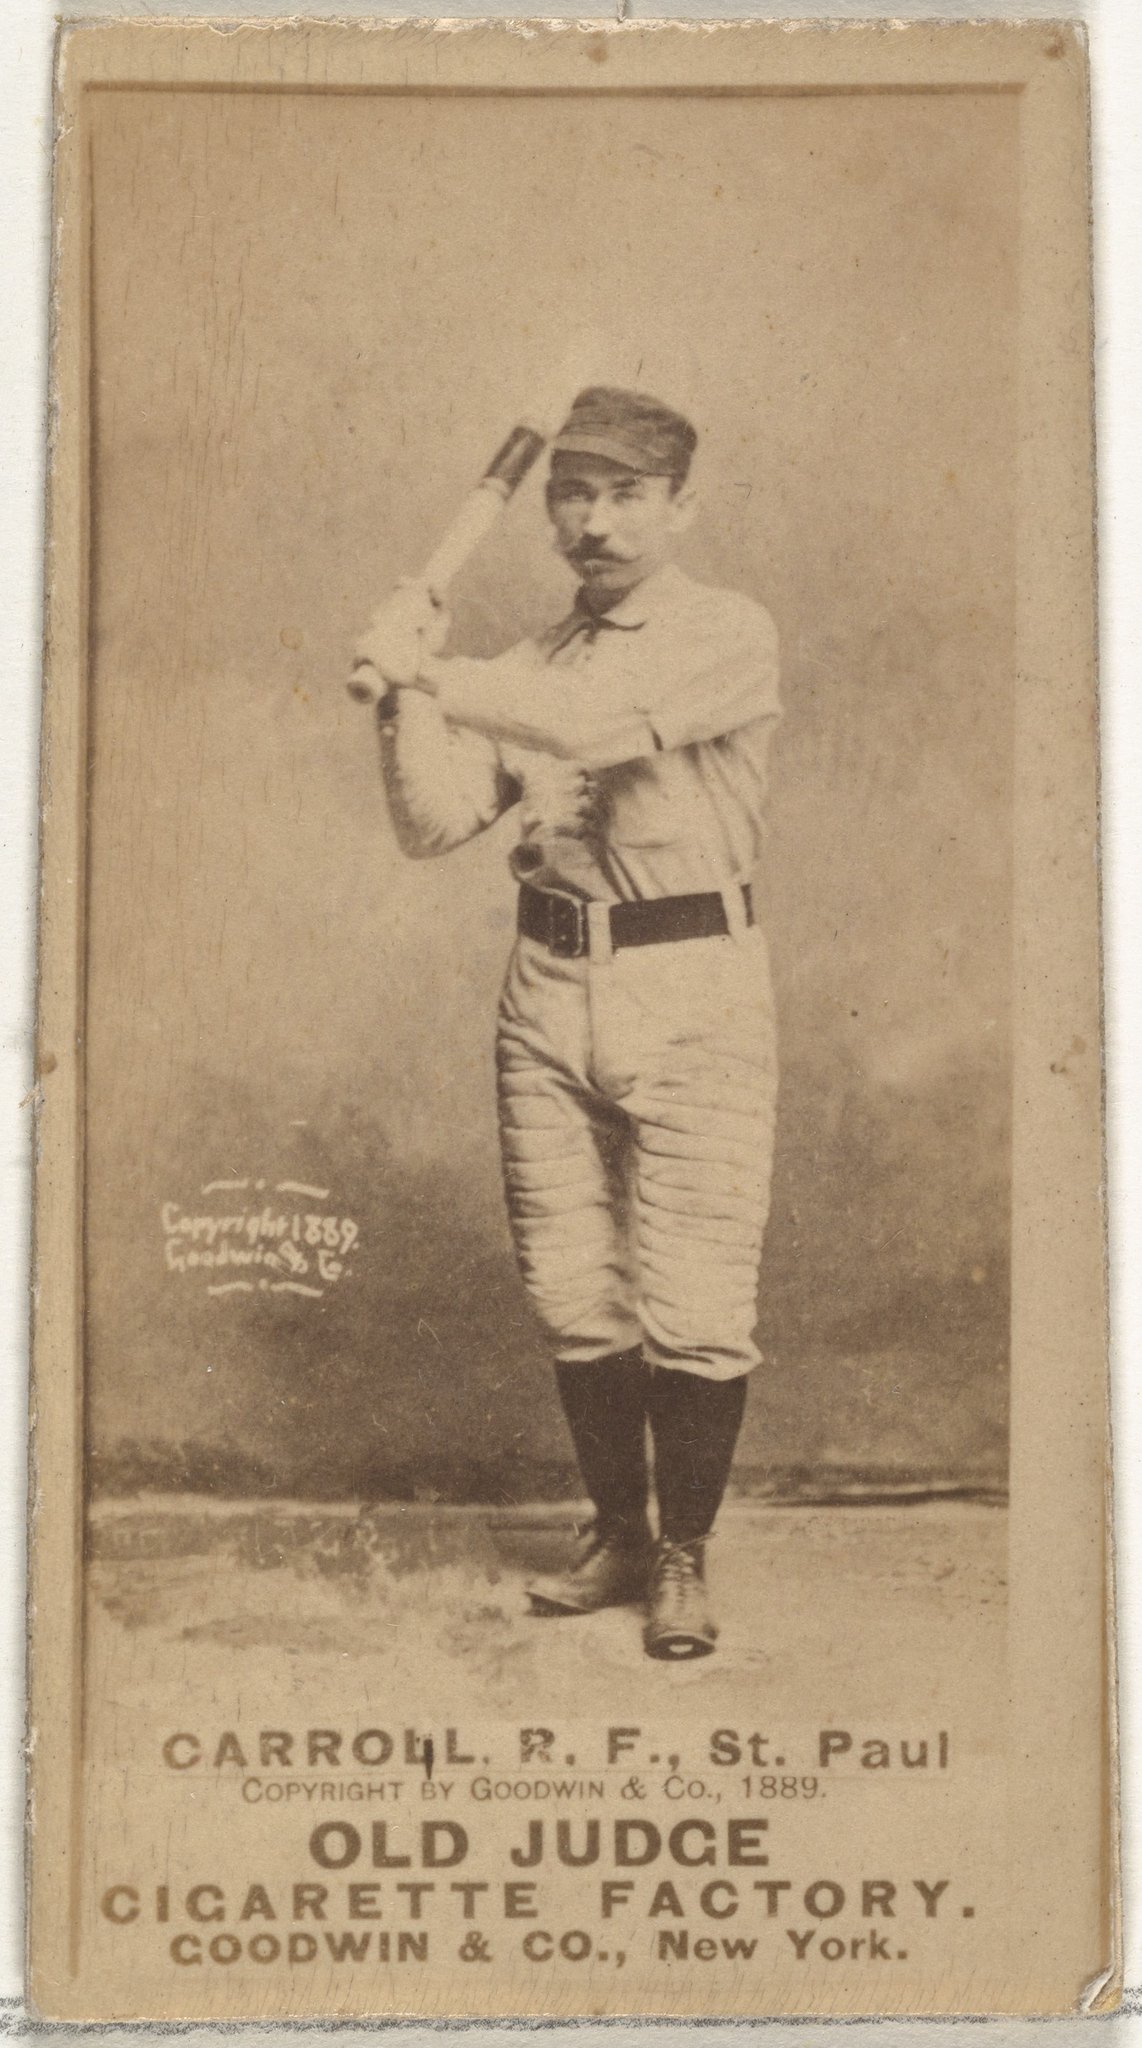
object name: baseball card, photograph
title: John E. "Scrappy" Carroll, Right Field, St. Paul Apostles, from the Old Judge series (N172) for Old Judge Cigarettes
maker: goodwin & company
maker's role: publisher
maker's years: 1850-1950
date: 1889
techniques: albumen silver print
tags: men,portraits,baseball,athletes